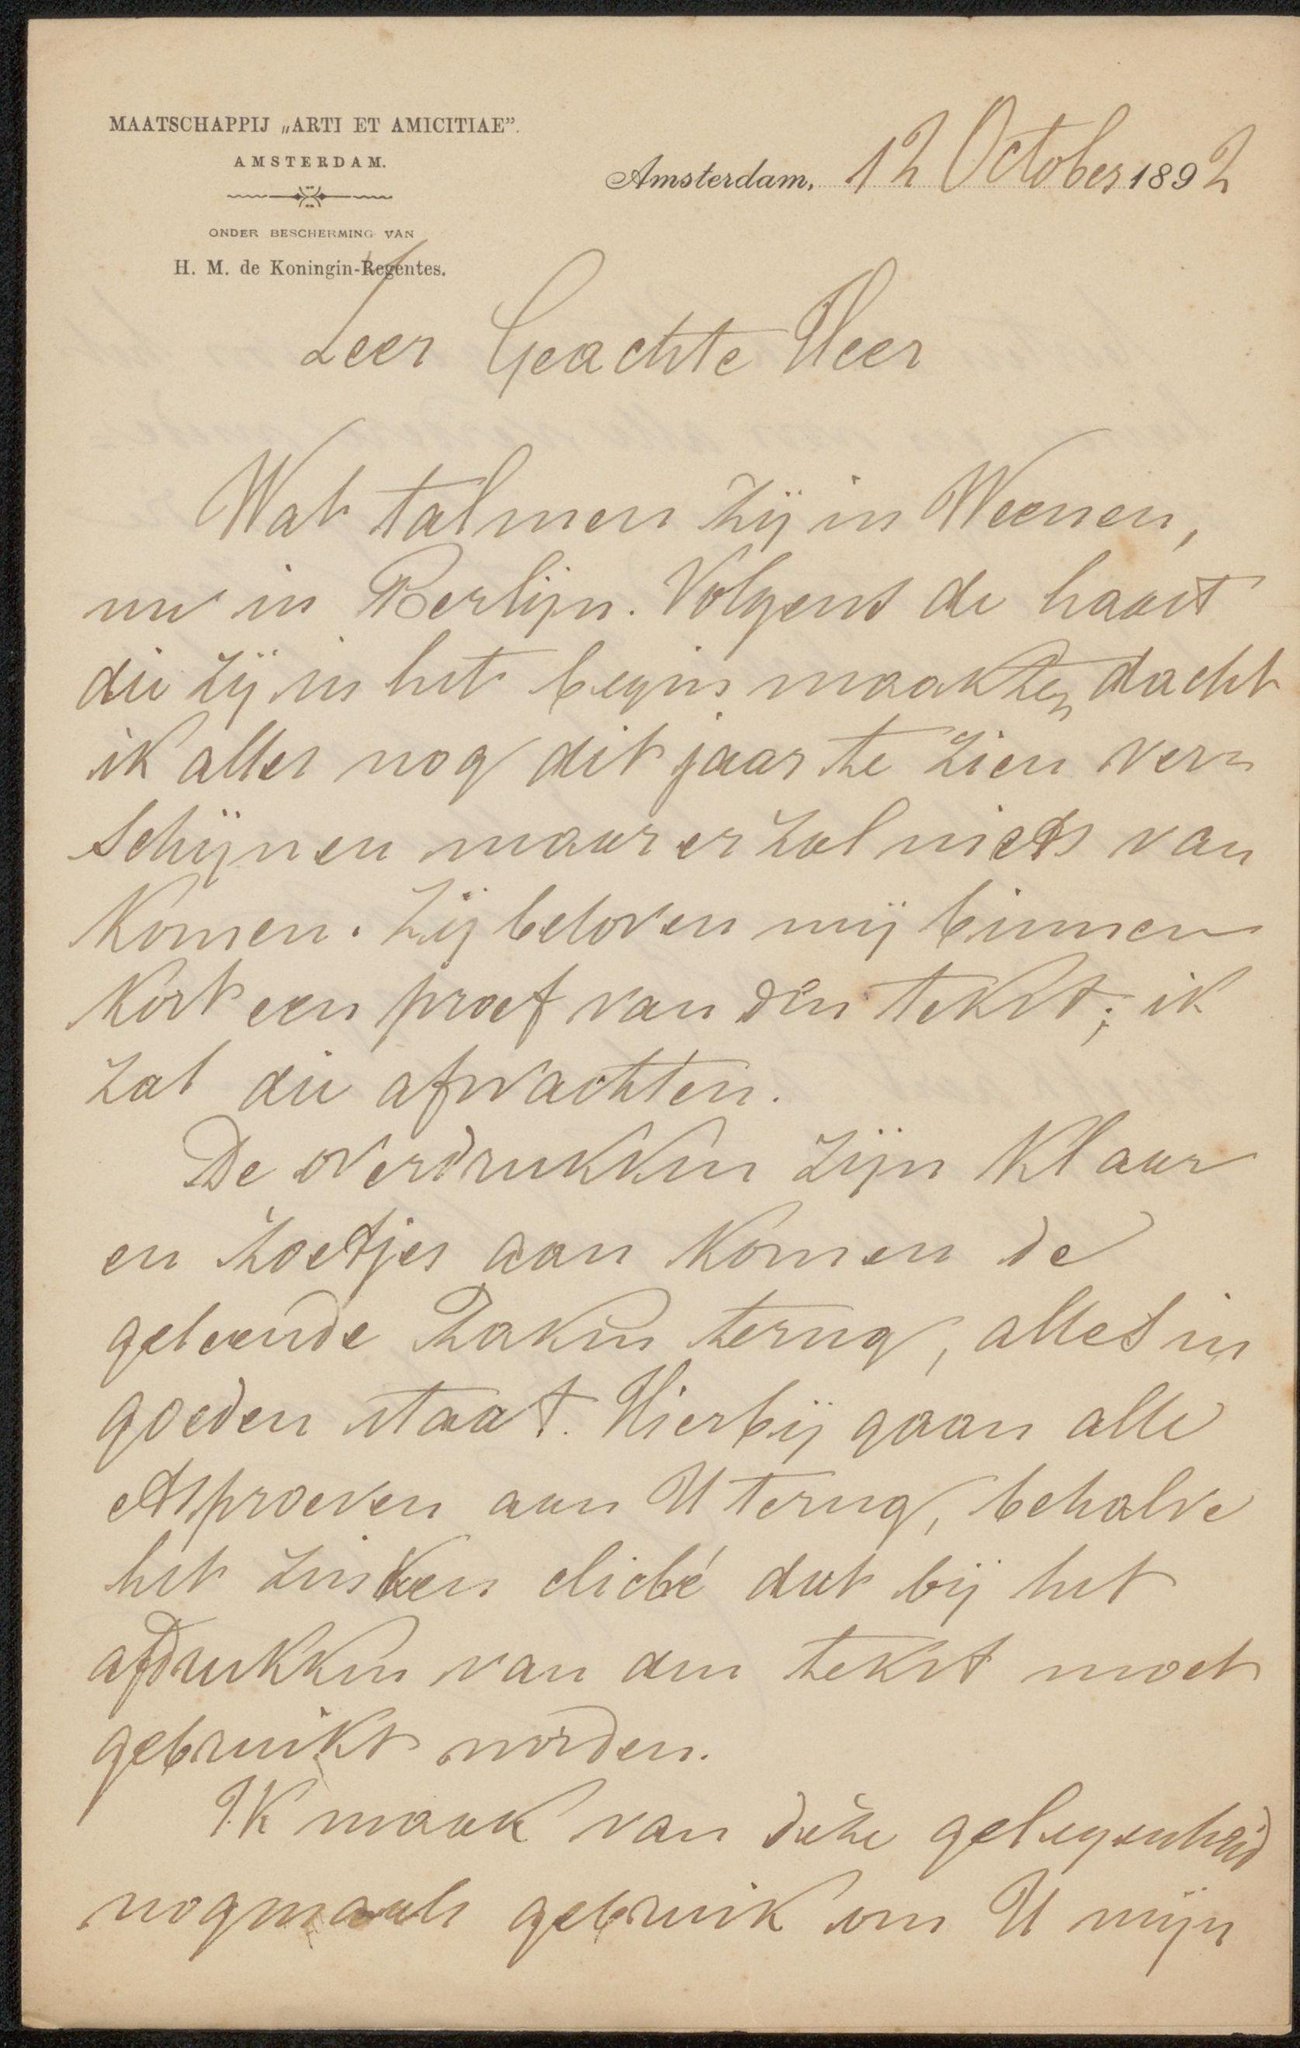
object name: letter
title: Brief aan Philip Zilcken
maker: edouard taurel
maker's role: draughtsman, print maker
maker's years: 1824-1892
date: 1892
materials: ink, paper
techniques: pen, printing, writing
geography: amsterdam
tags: the hague, painter, draughtsman, philip zilcken, printed matter, vienna, berlin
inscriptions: collector's mark: ‘RPK’